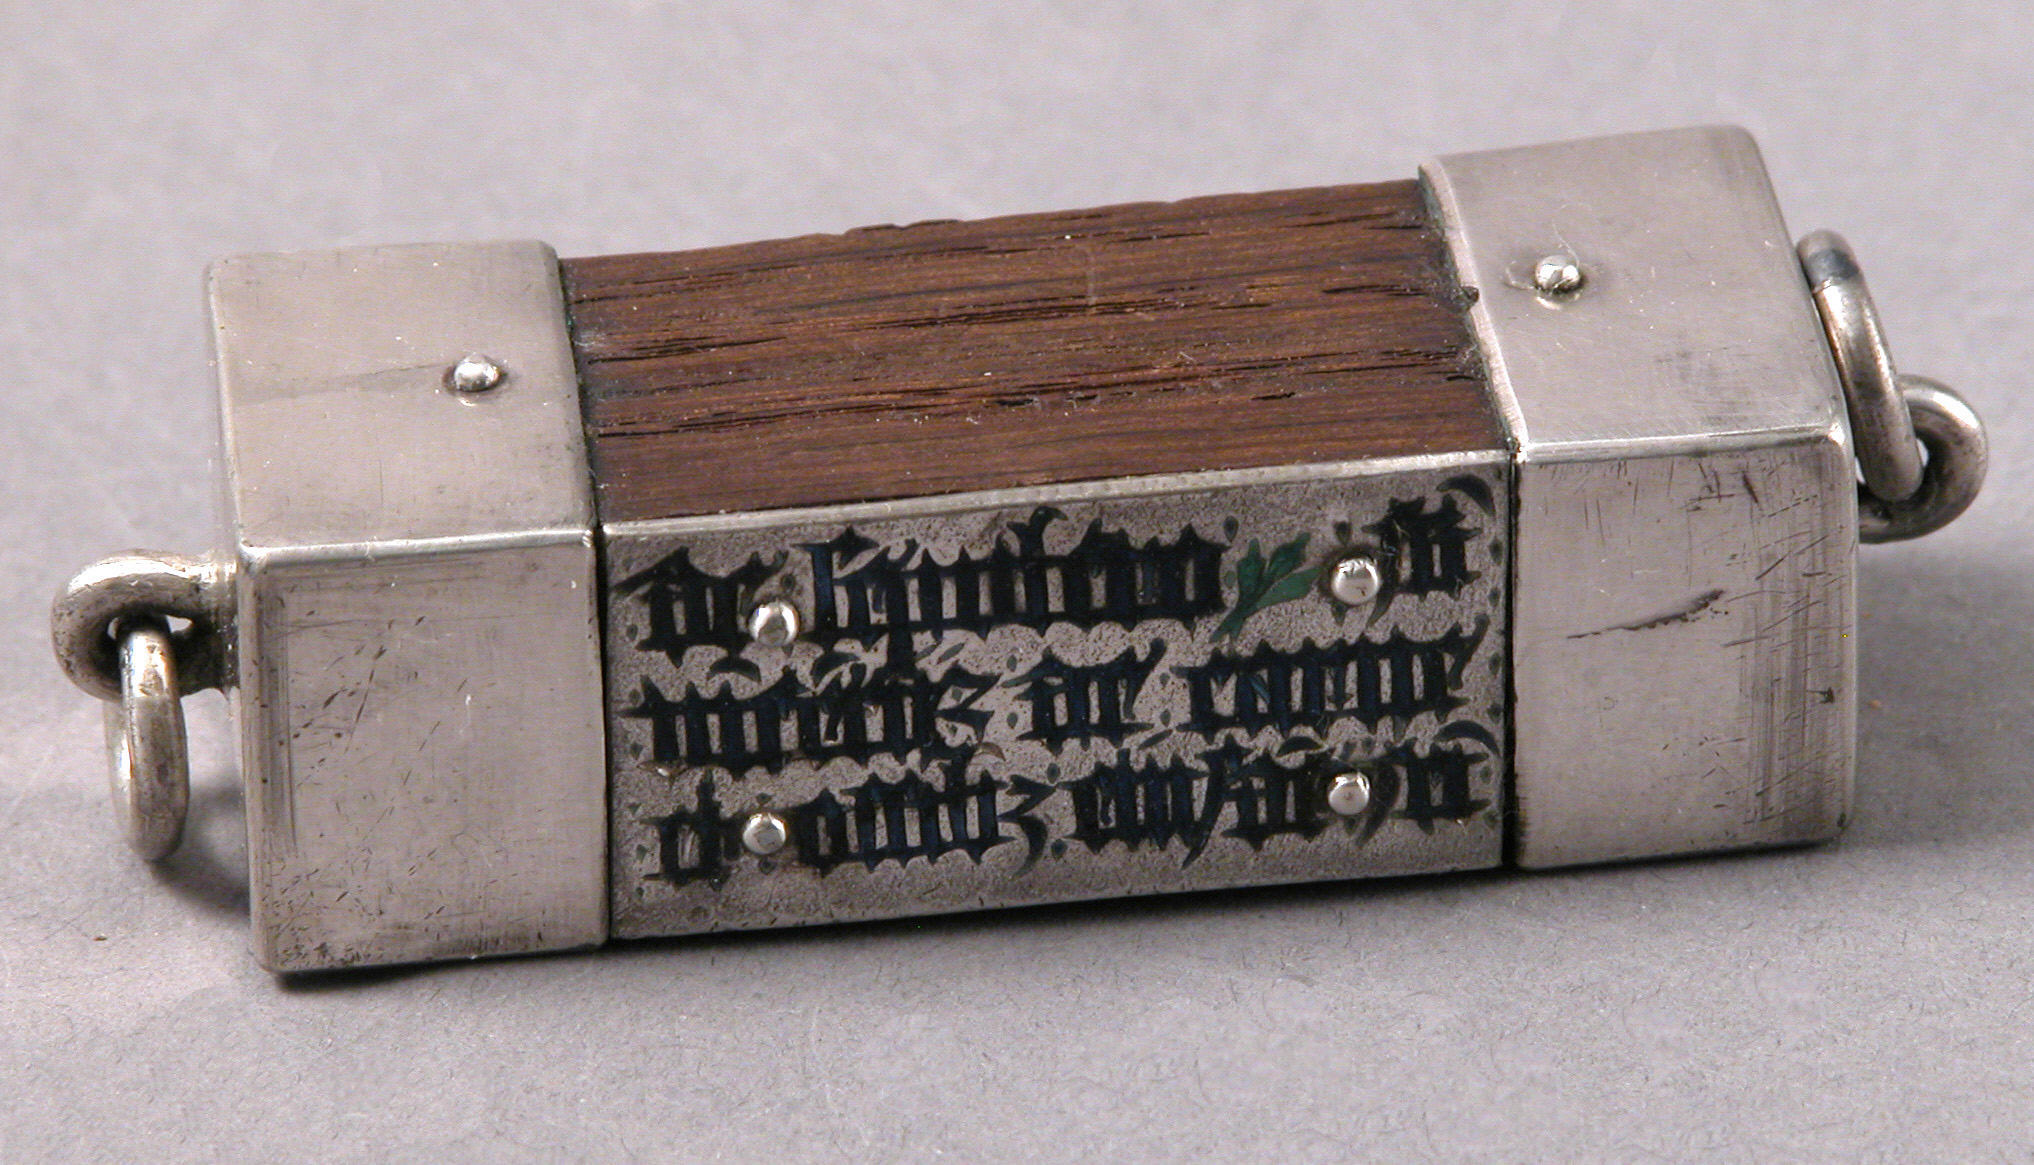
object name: reliquary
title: Portable Reliquary of Saint Vincent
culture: french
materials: enamel, silver, wood